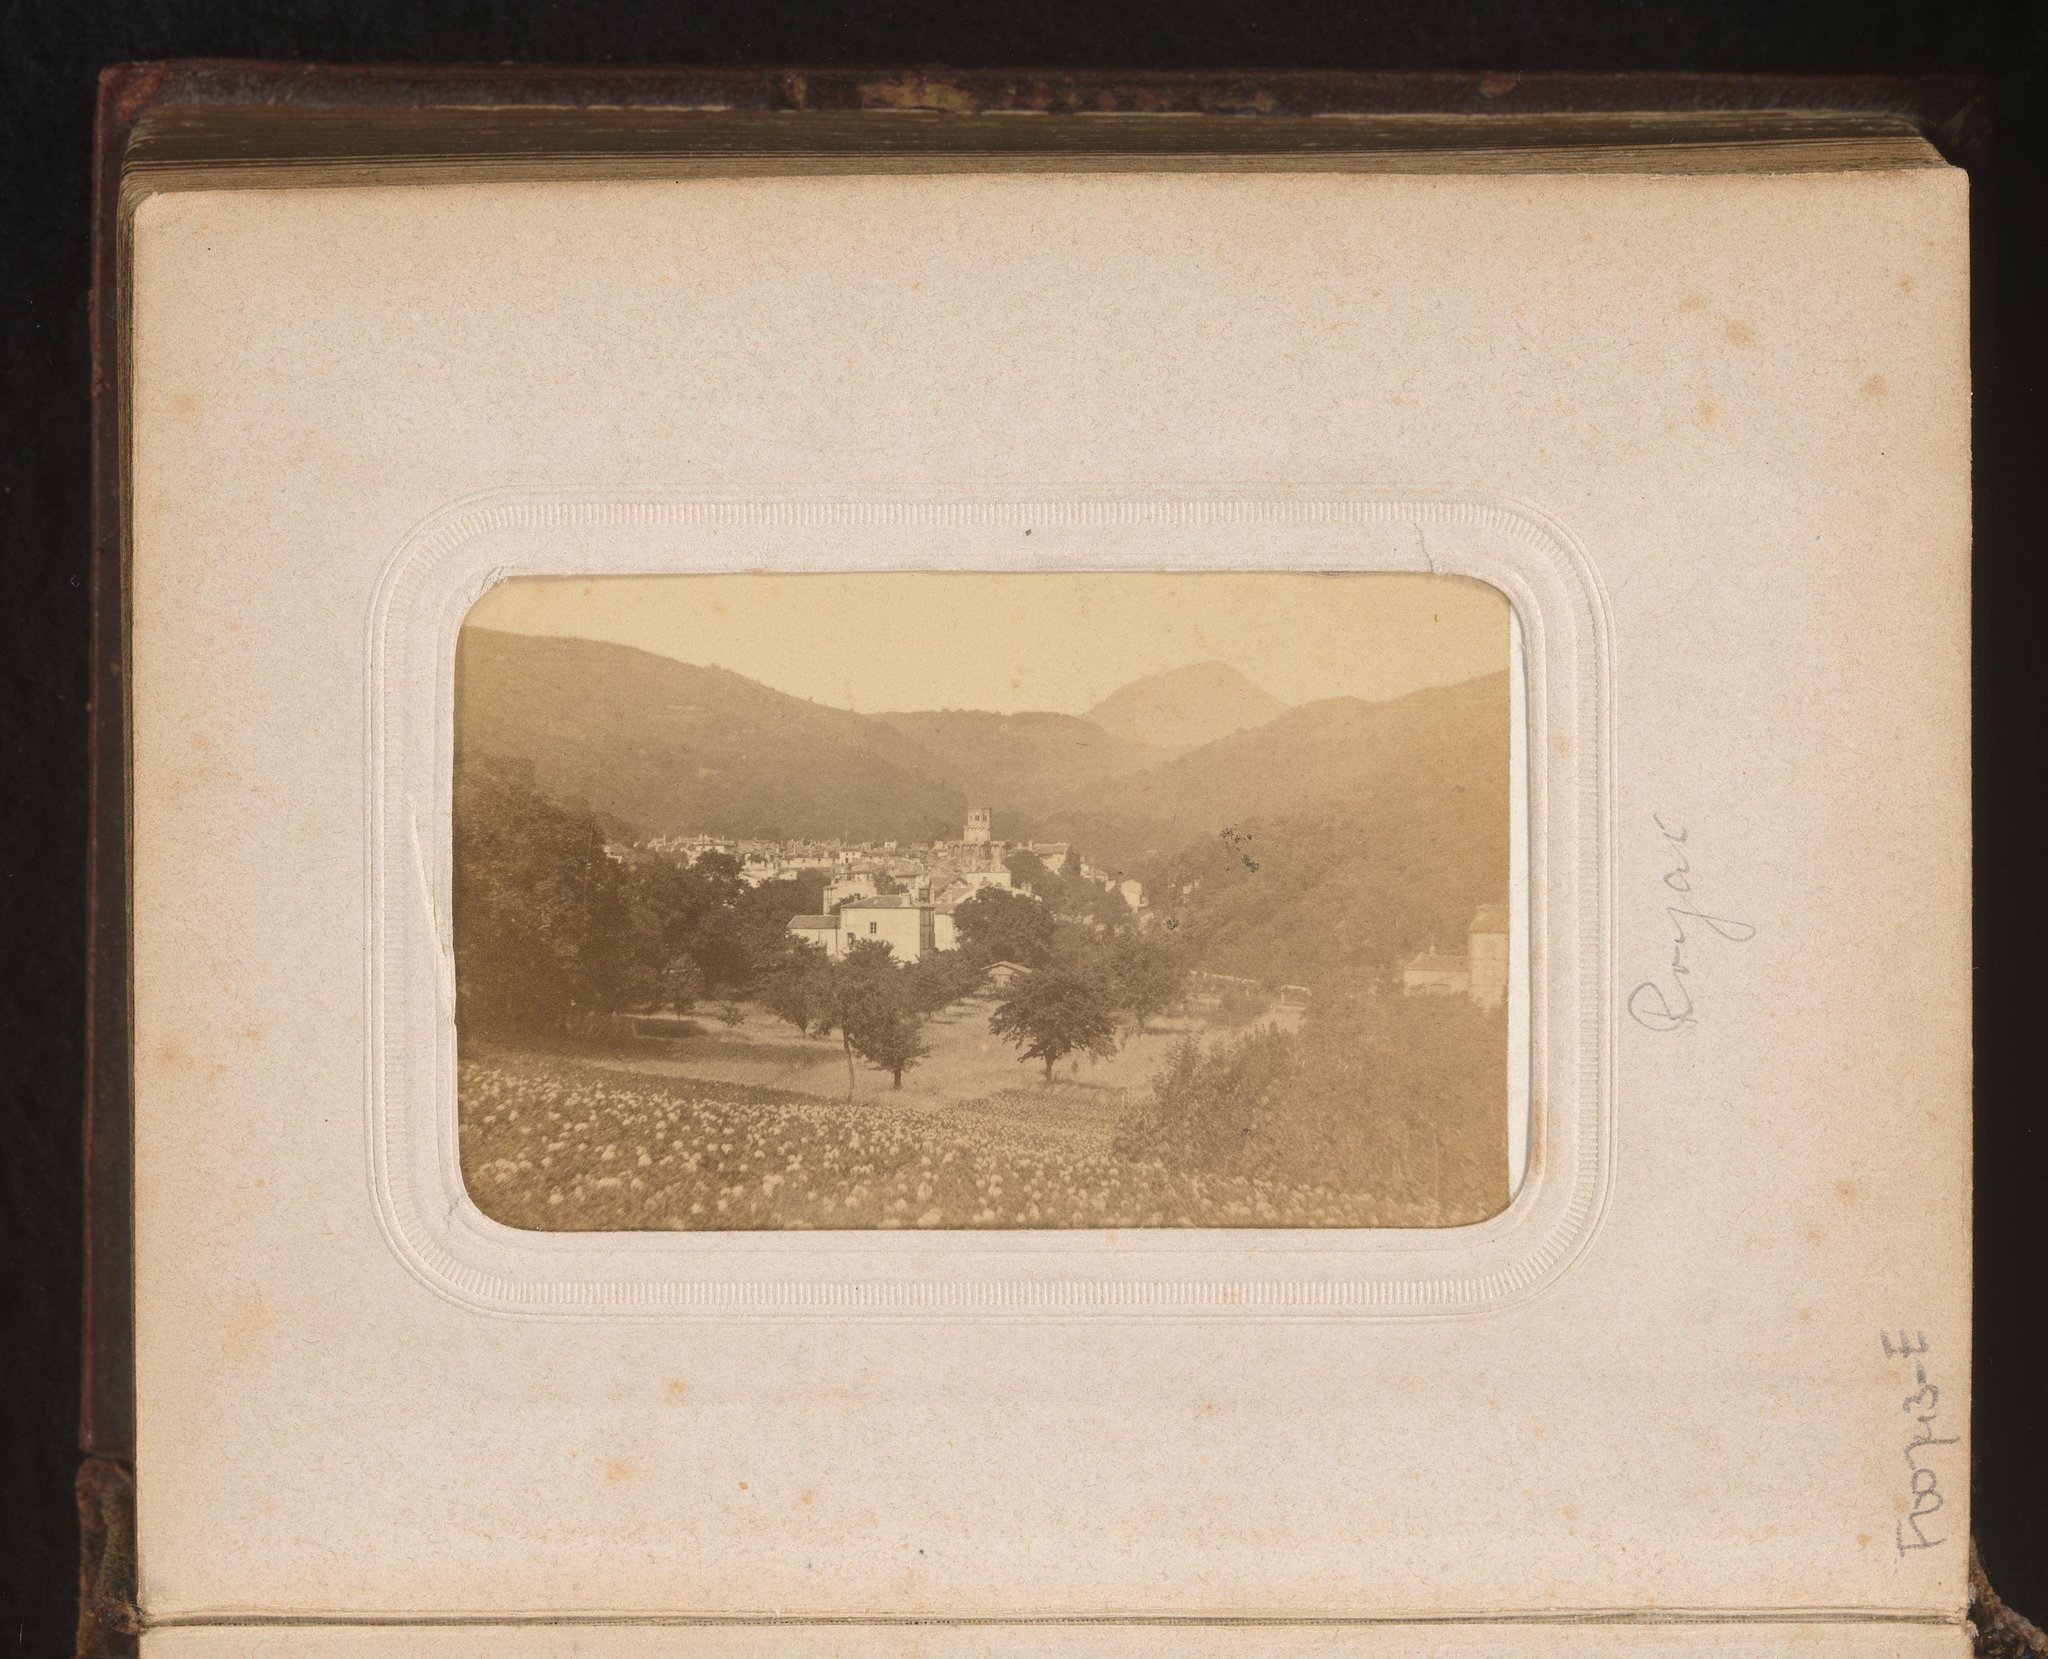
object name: photograph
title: Gezicht op Royat, Frankrijk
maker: jean baptiste berubet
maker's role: fotograaf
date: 1860-1880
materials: cardboard, photographic support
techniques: albumen print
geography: royat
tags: prospect of village, silhouette of village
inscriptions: annotation: ‘Vallée et Village de Royat’, inscription: ‘Berubet/ PHOTOGRAPHE-OPTICIEN/ Place St. Herem, No 19/ CLERMONT-FERRAND’, annotation: ‘Royat’